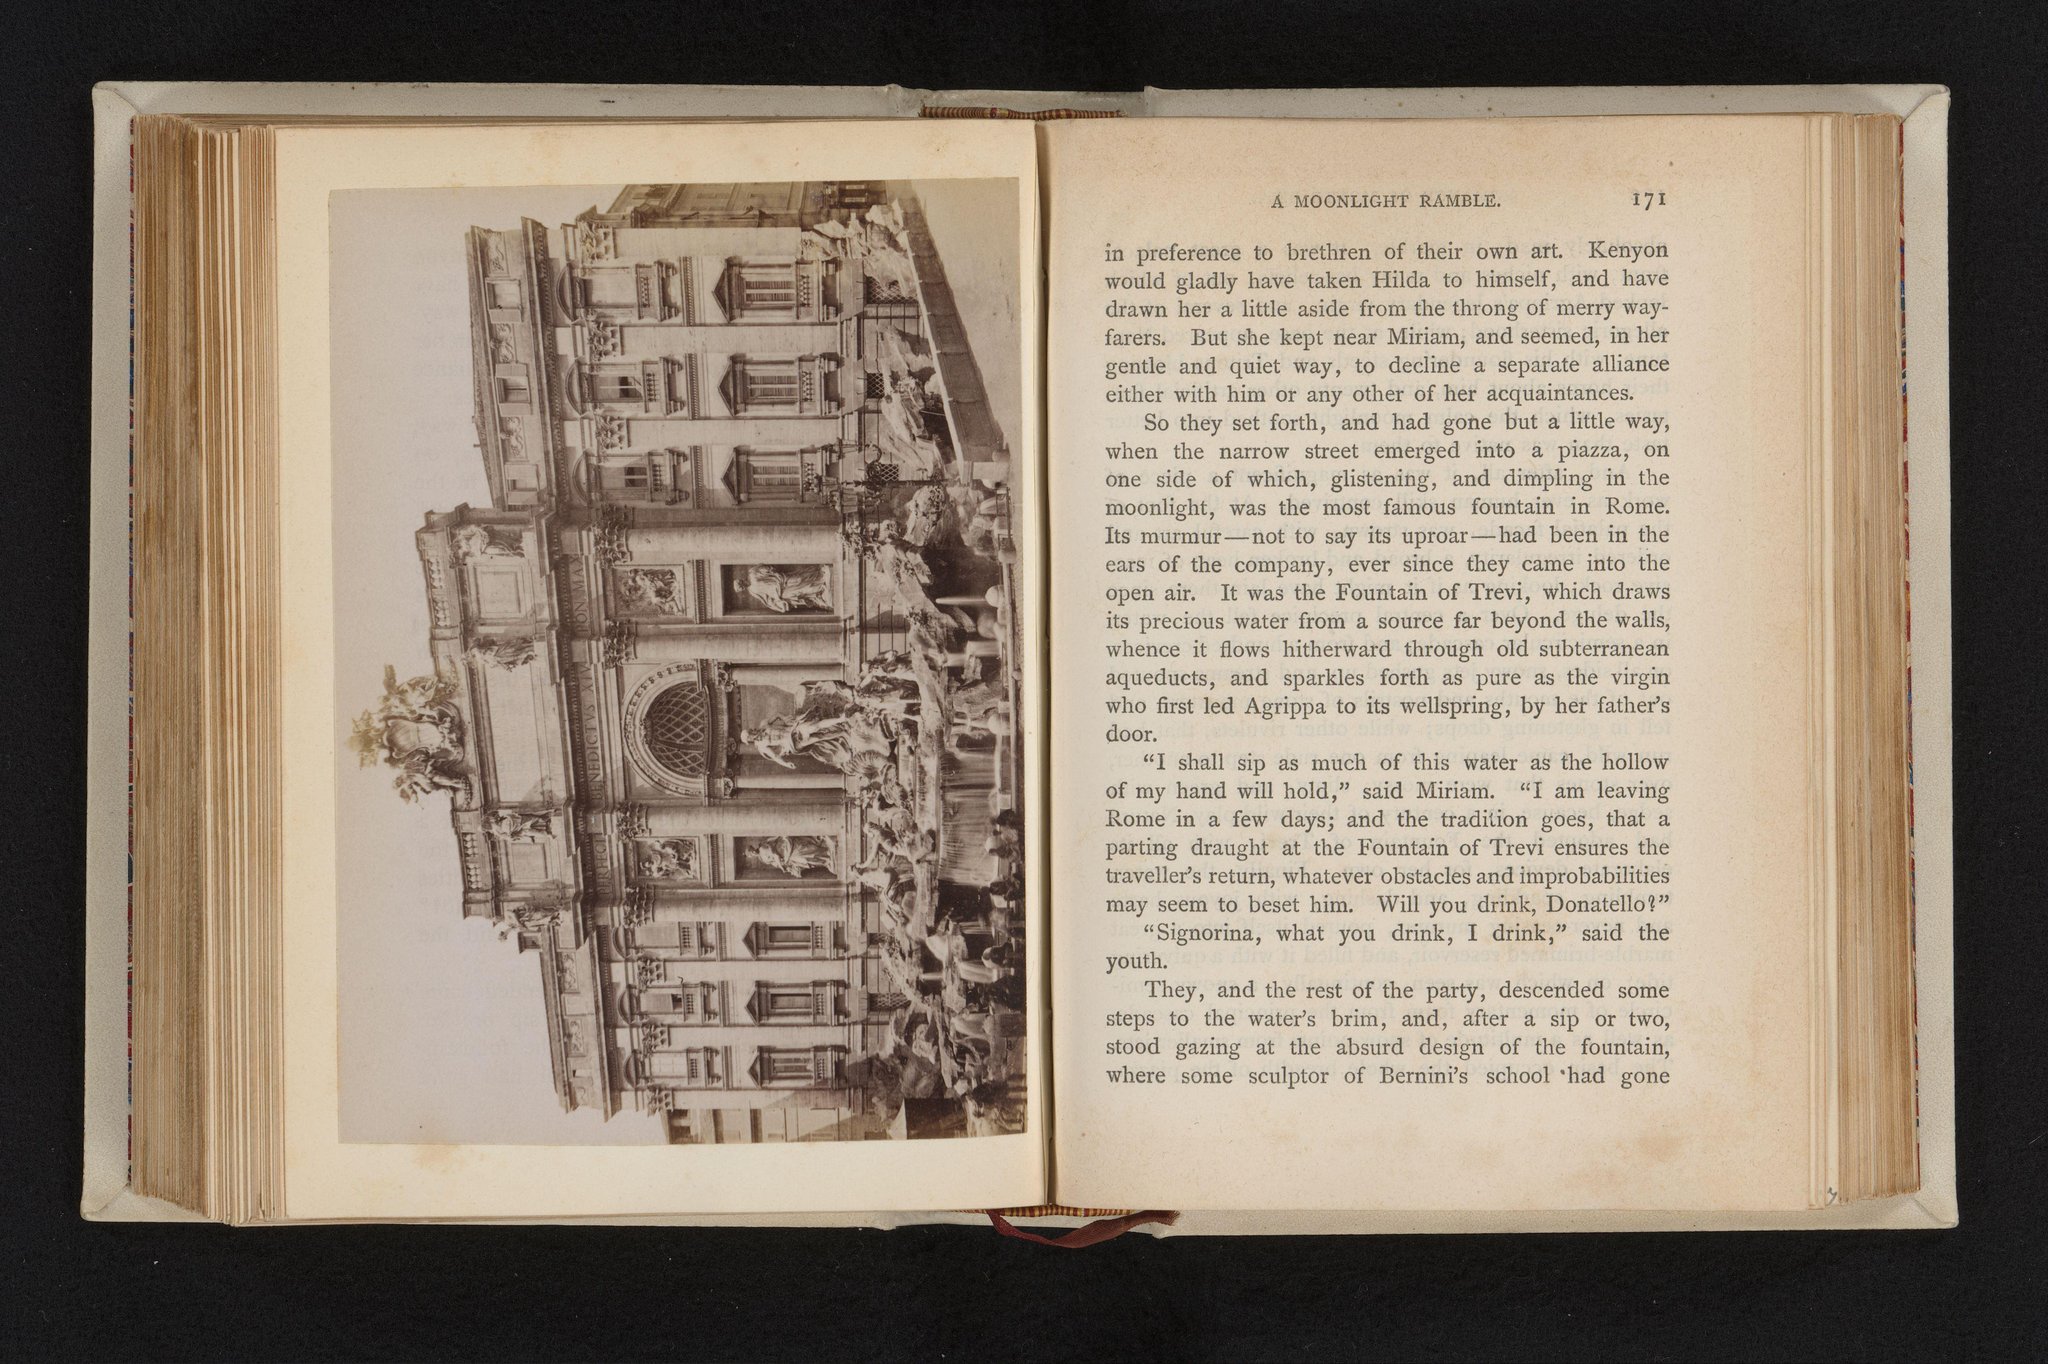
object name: photograph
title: Gezicht op de Trevifontein in Rome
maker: Anonymous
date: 1850-1860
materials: photographic support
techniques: albumen print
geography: rome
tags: ornamental fountain